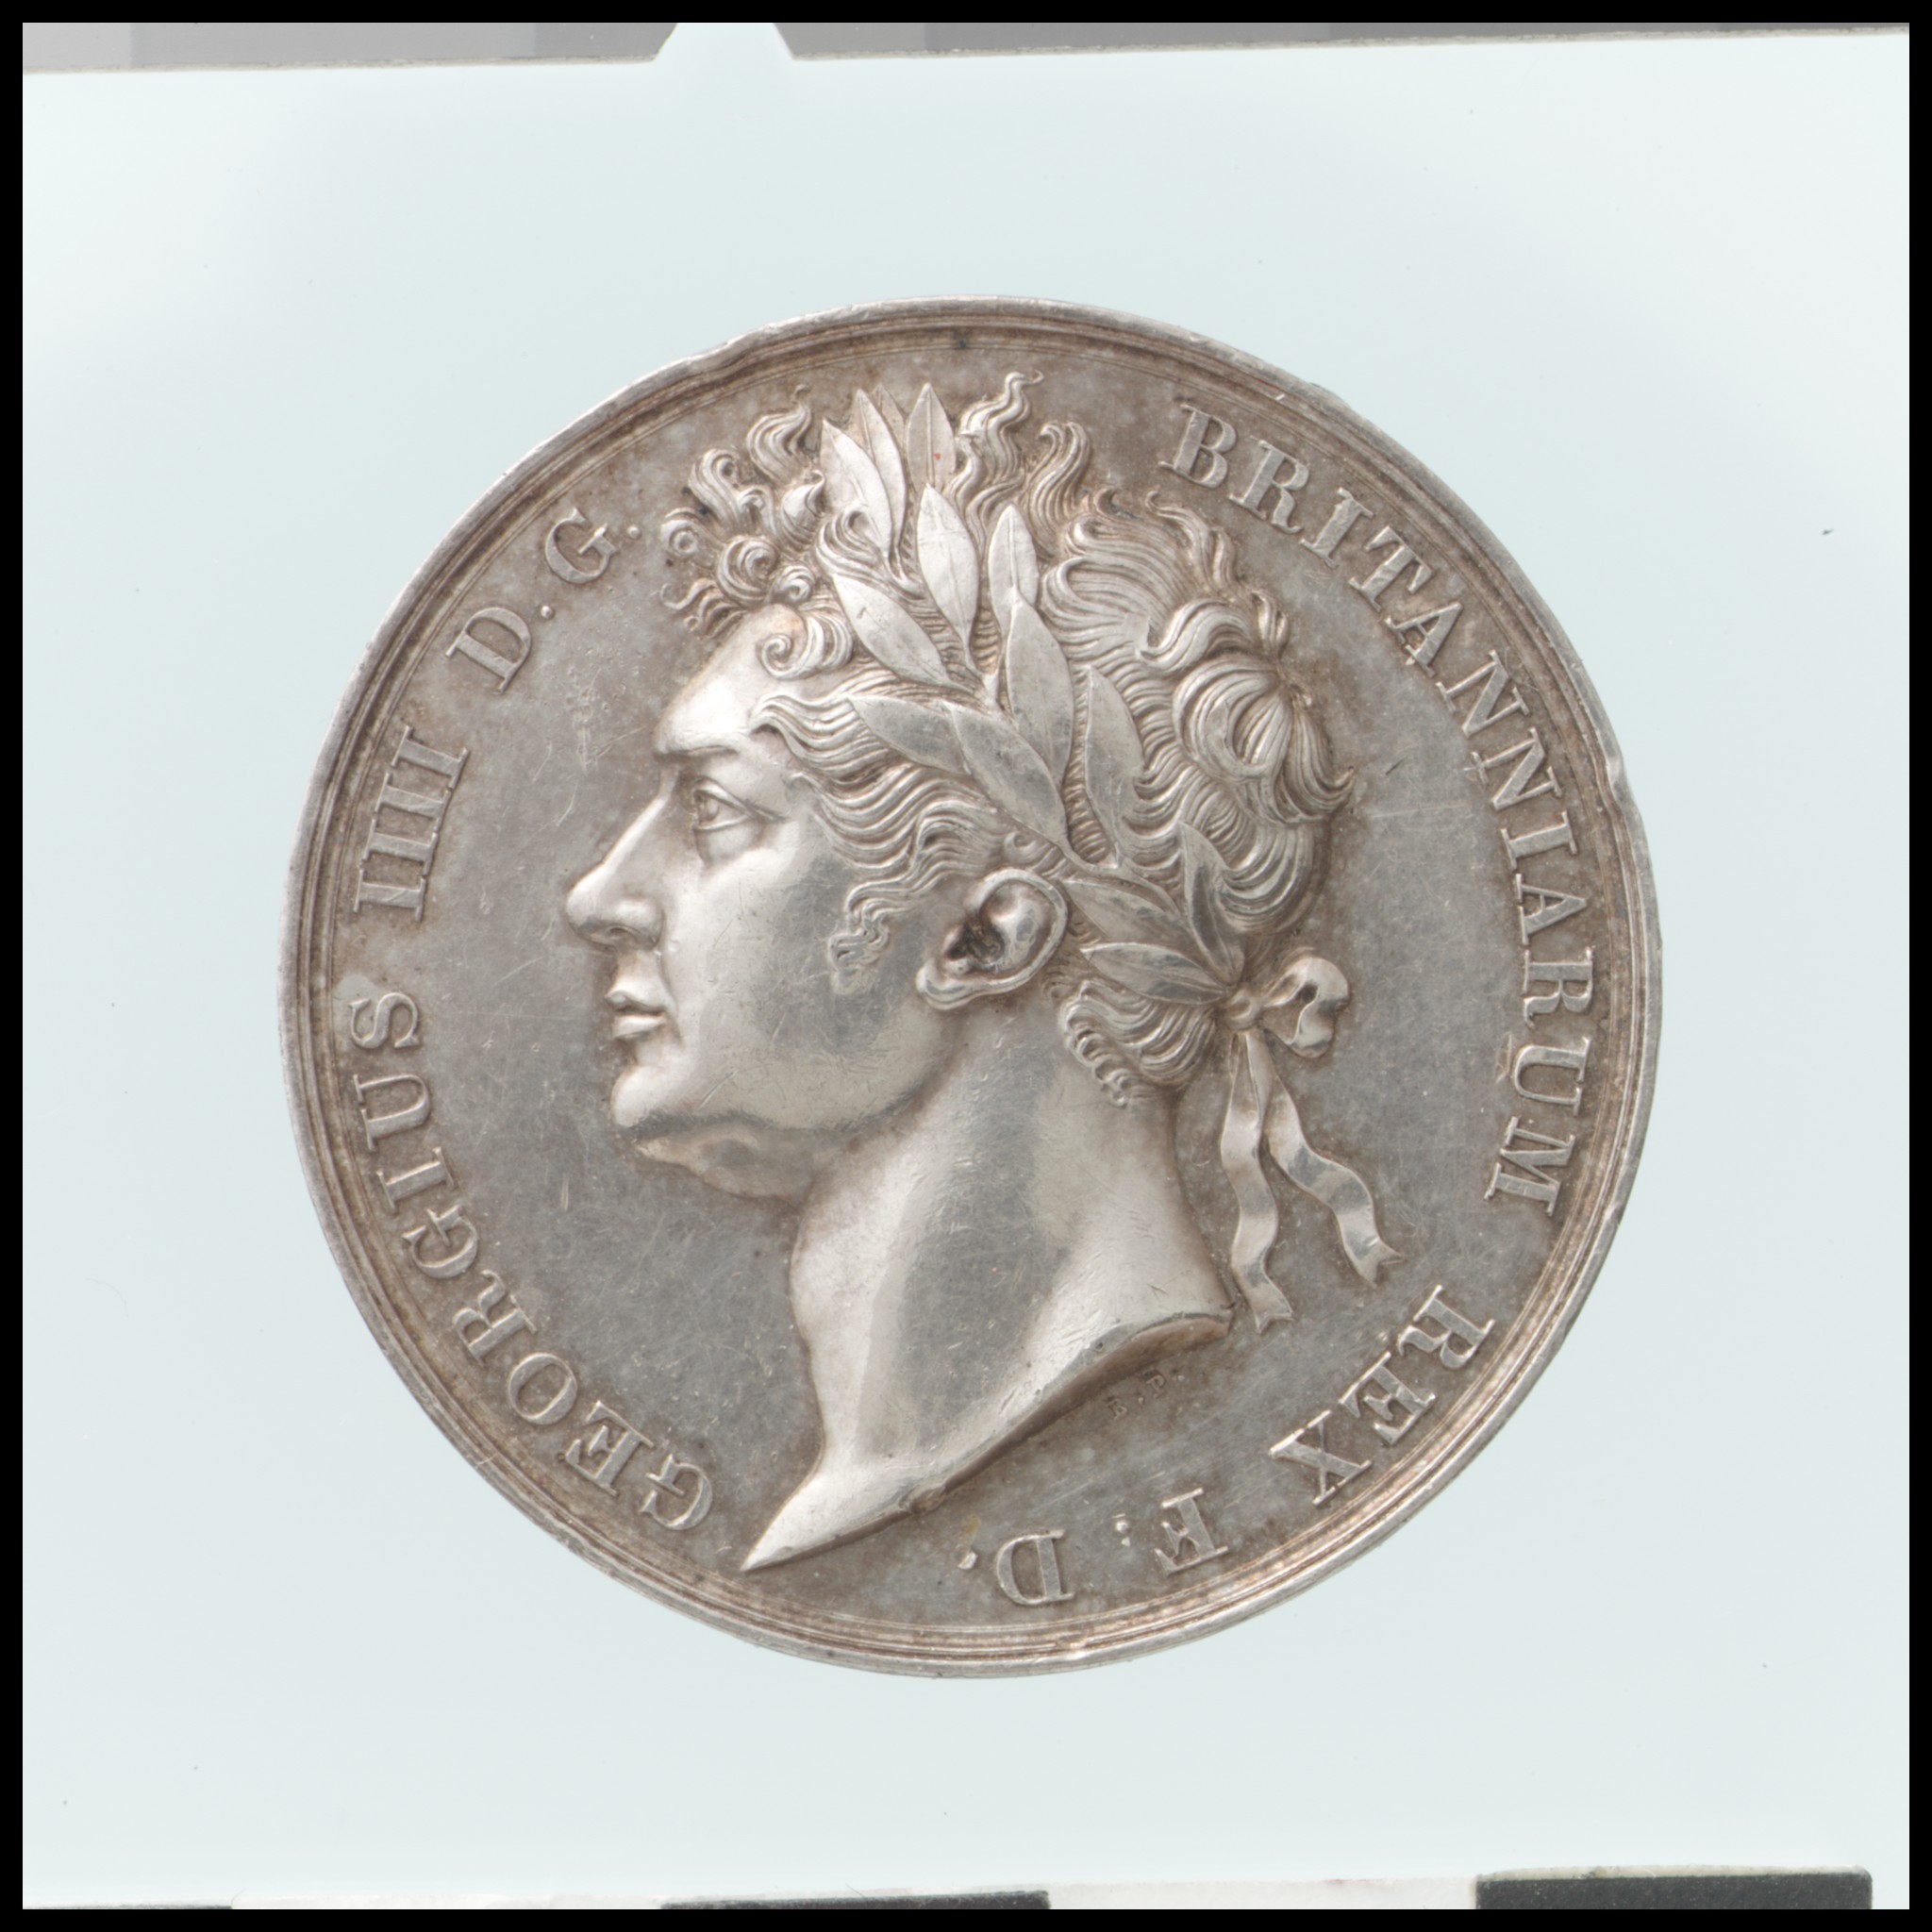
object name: medal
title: Coronation of George IV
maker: benedetto pistrucci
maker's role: maker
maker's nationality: italian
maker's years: 1783-1855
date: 1821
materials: silver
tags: kings,men,profiles